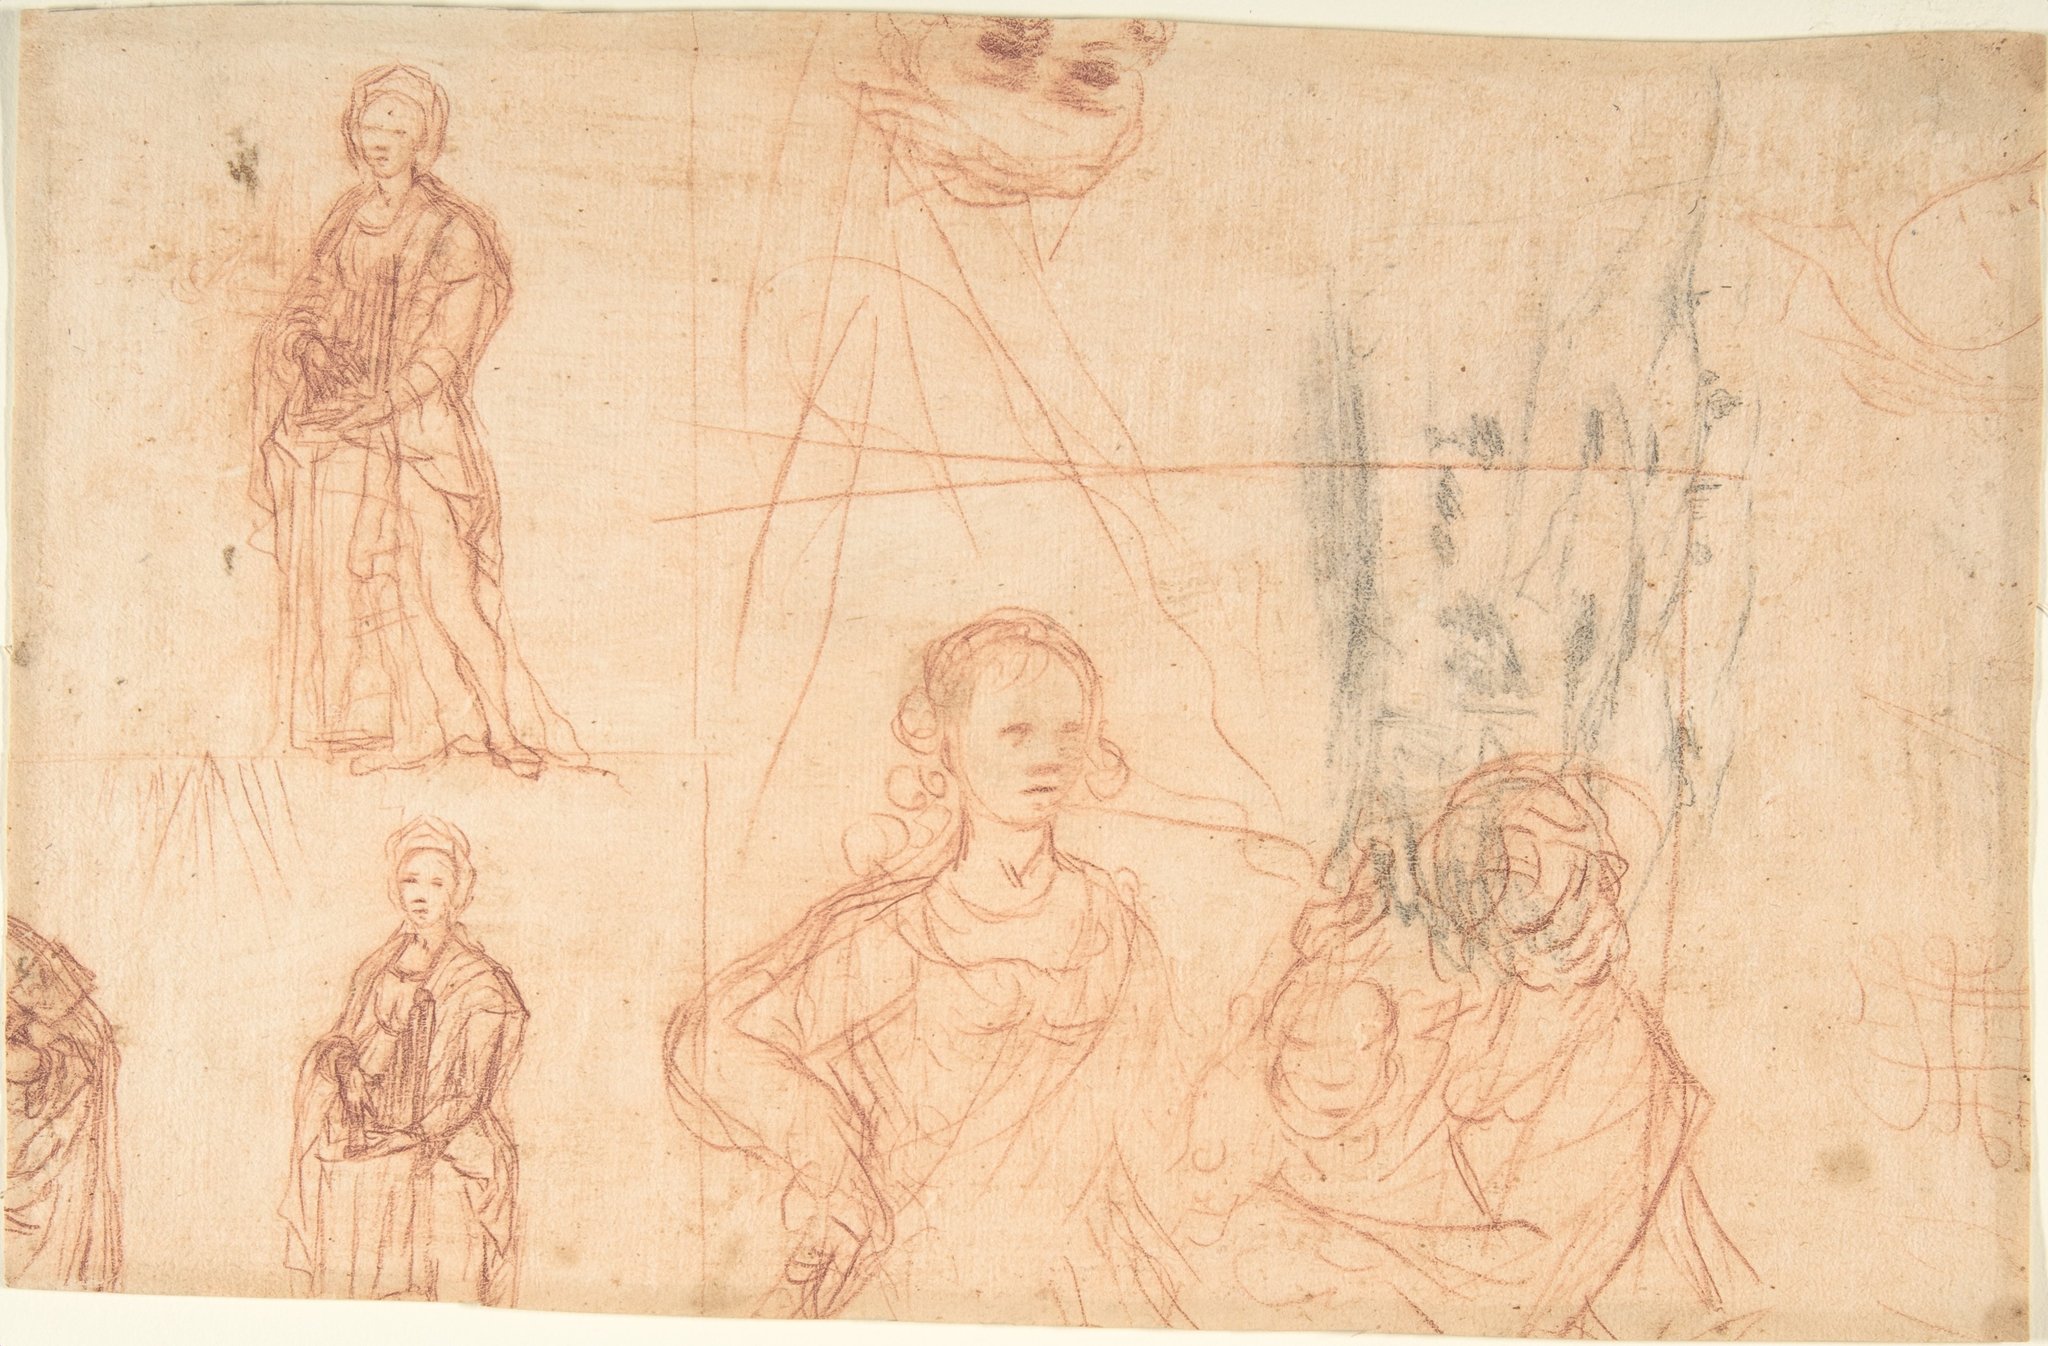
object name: drawing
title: Figure Studies; Landscape (recto); Copy after Antique Style Hercules Statue (verso)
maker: anonymous, italian, florentine, second half of the 16th century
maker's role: artist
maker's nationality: italian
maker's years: 1550-1600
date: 1580-1620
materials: chalk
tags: human figures